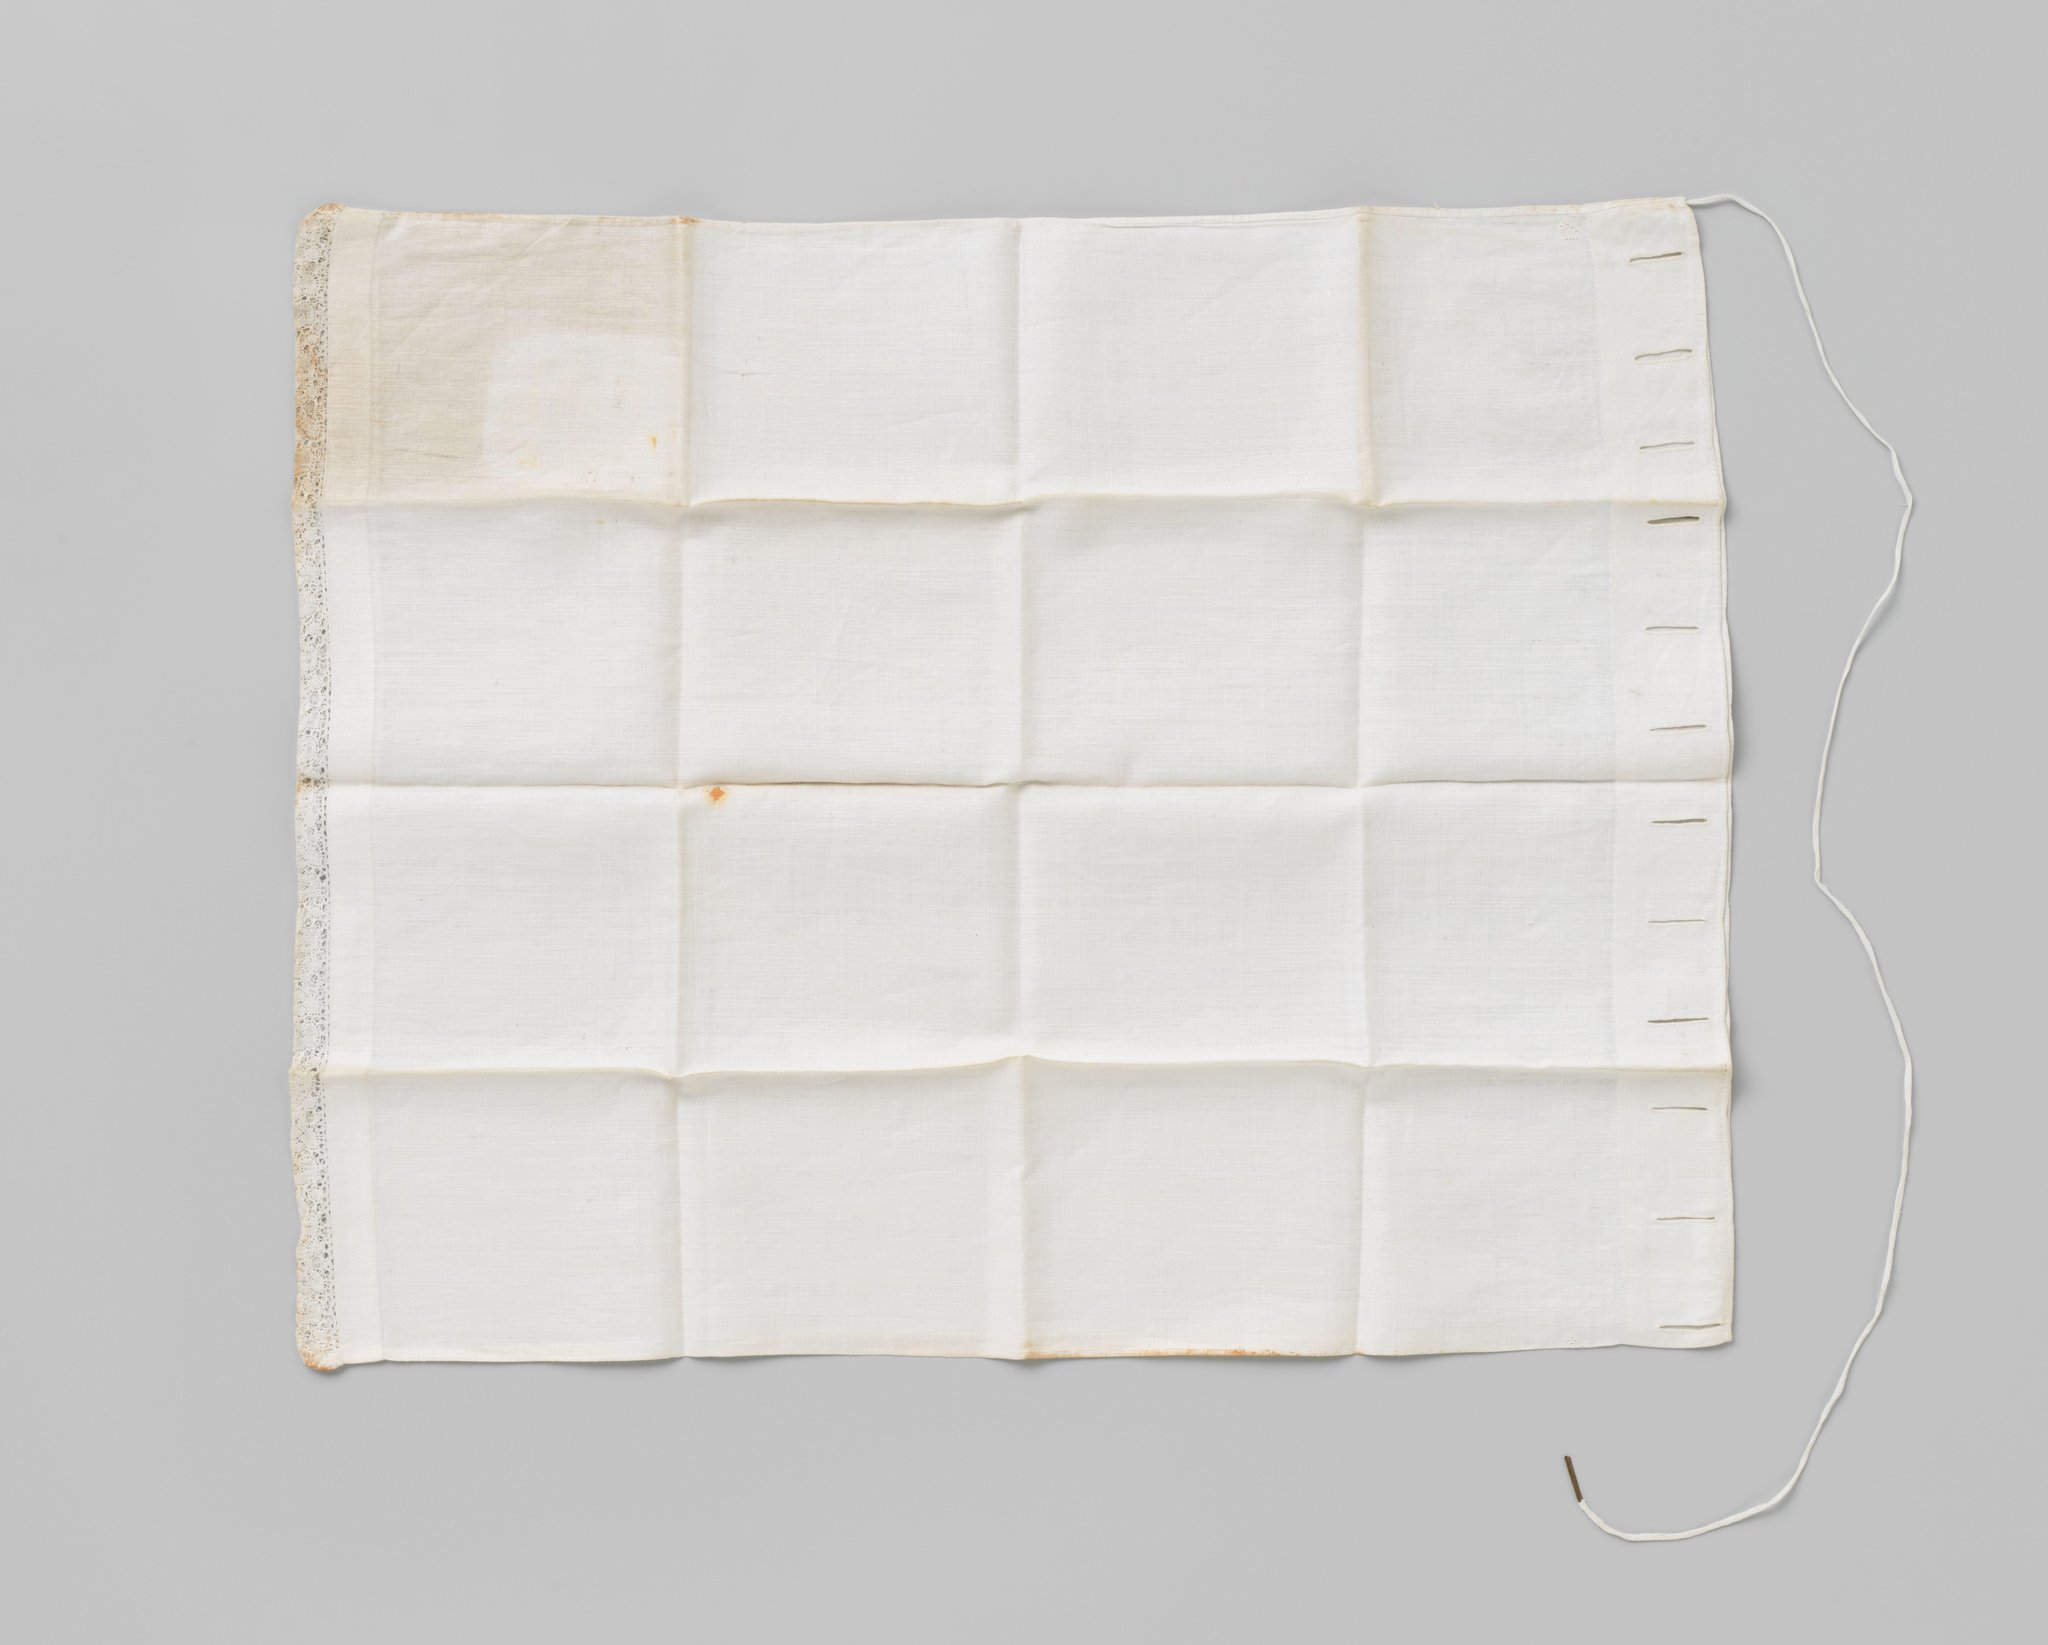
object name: lendensloop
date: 1734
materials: linen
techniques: lace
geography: northern netherlands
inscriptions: date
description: Lendensloop van linnen met entre-deux van kloskant, merk kroon B en 1734.